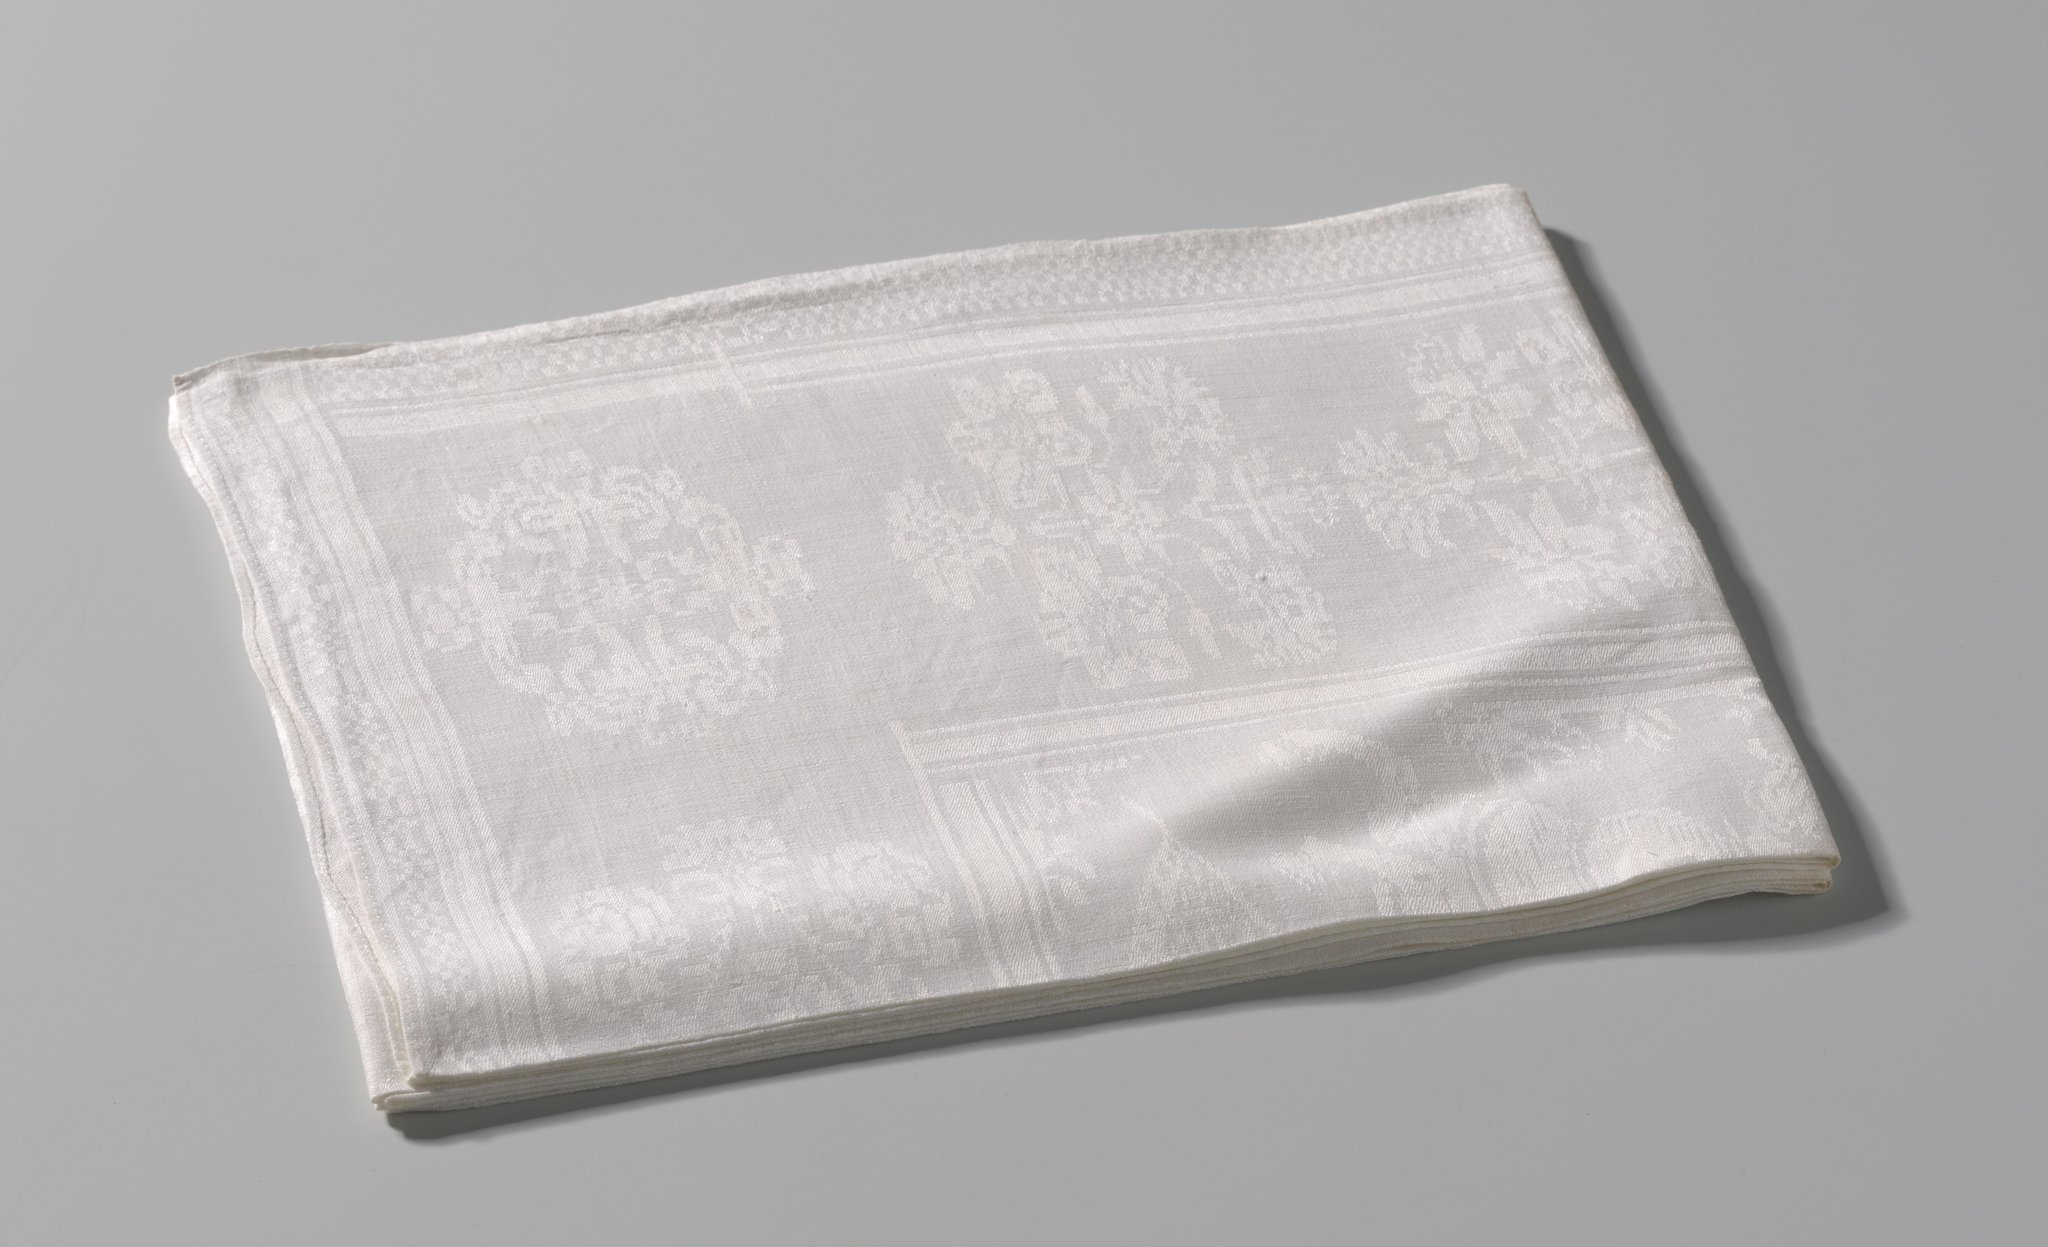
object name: napkin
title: Servet van wit linnendamast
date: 1706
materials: linen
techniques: damask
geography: flanders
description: Wit linnen damasten servet met taferelen uit de Spaanse Successie-Oorlog en de inweving "PRINC ET DVX DE MARLOBORVGH BELGIVM DEBELLAVIT" en "ANVERS", "MALINIS", "BRVSSEL", "LOVEN", "GENDT", "BRVGGE", "OSSTENDE" en "MEENEN".